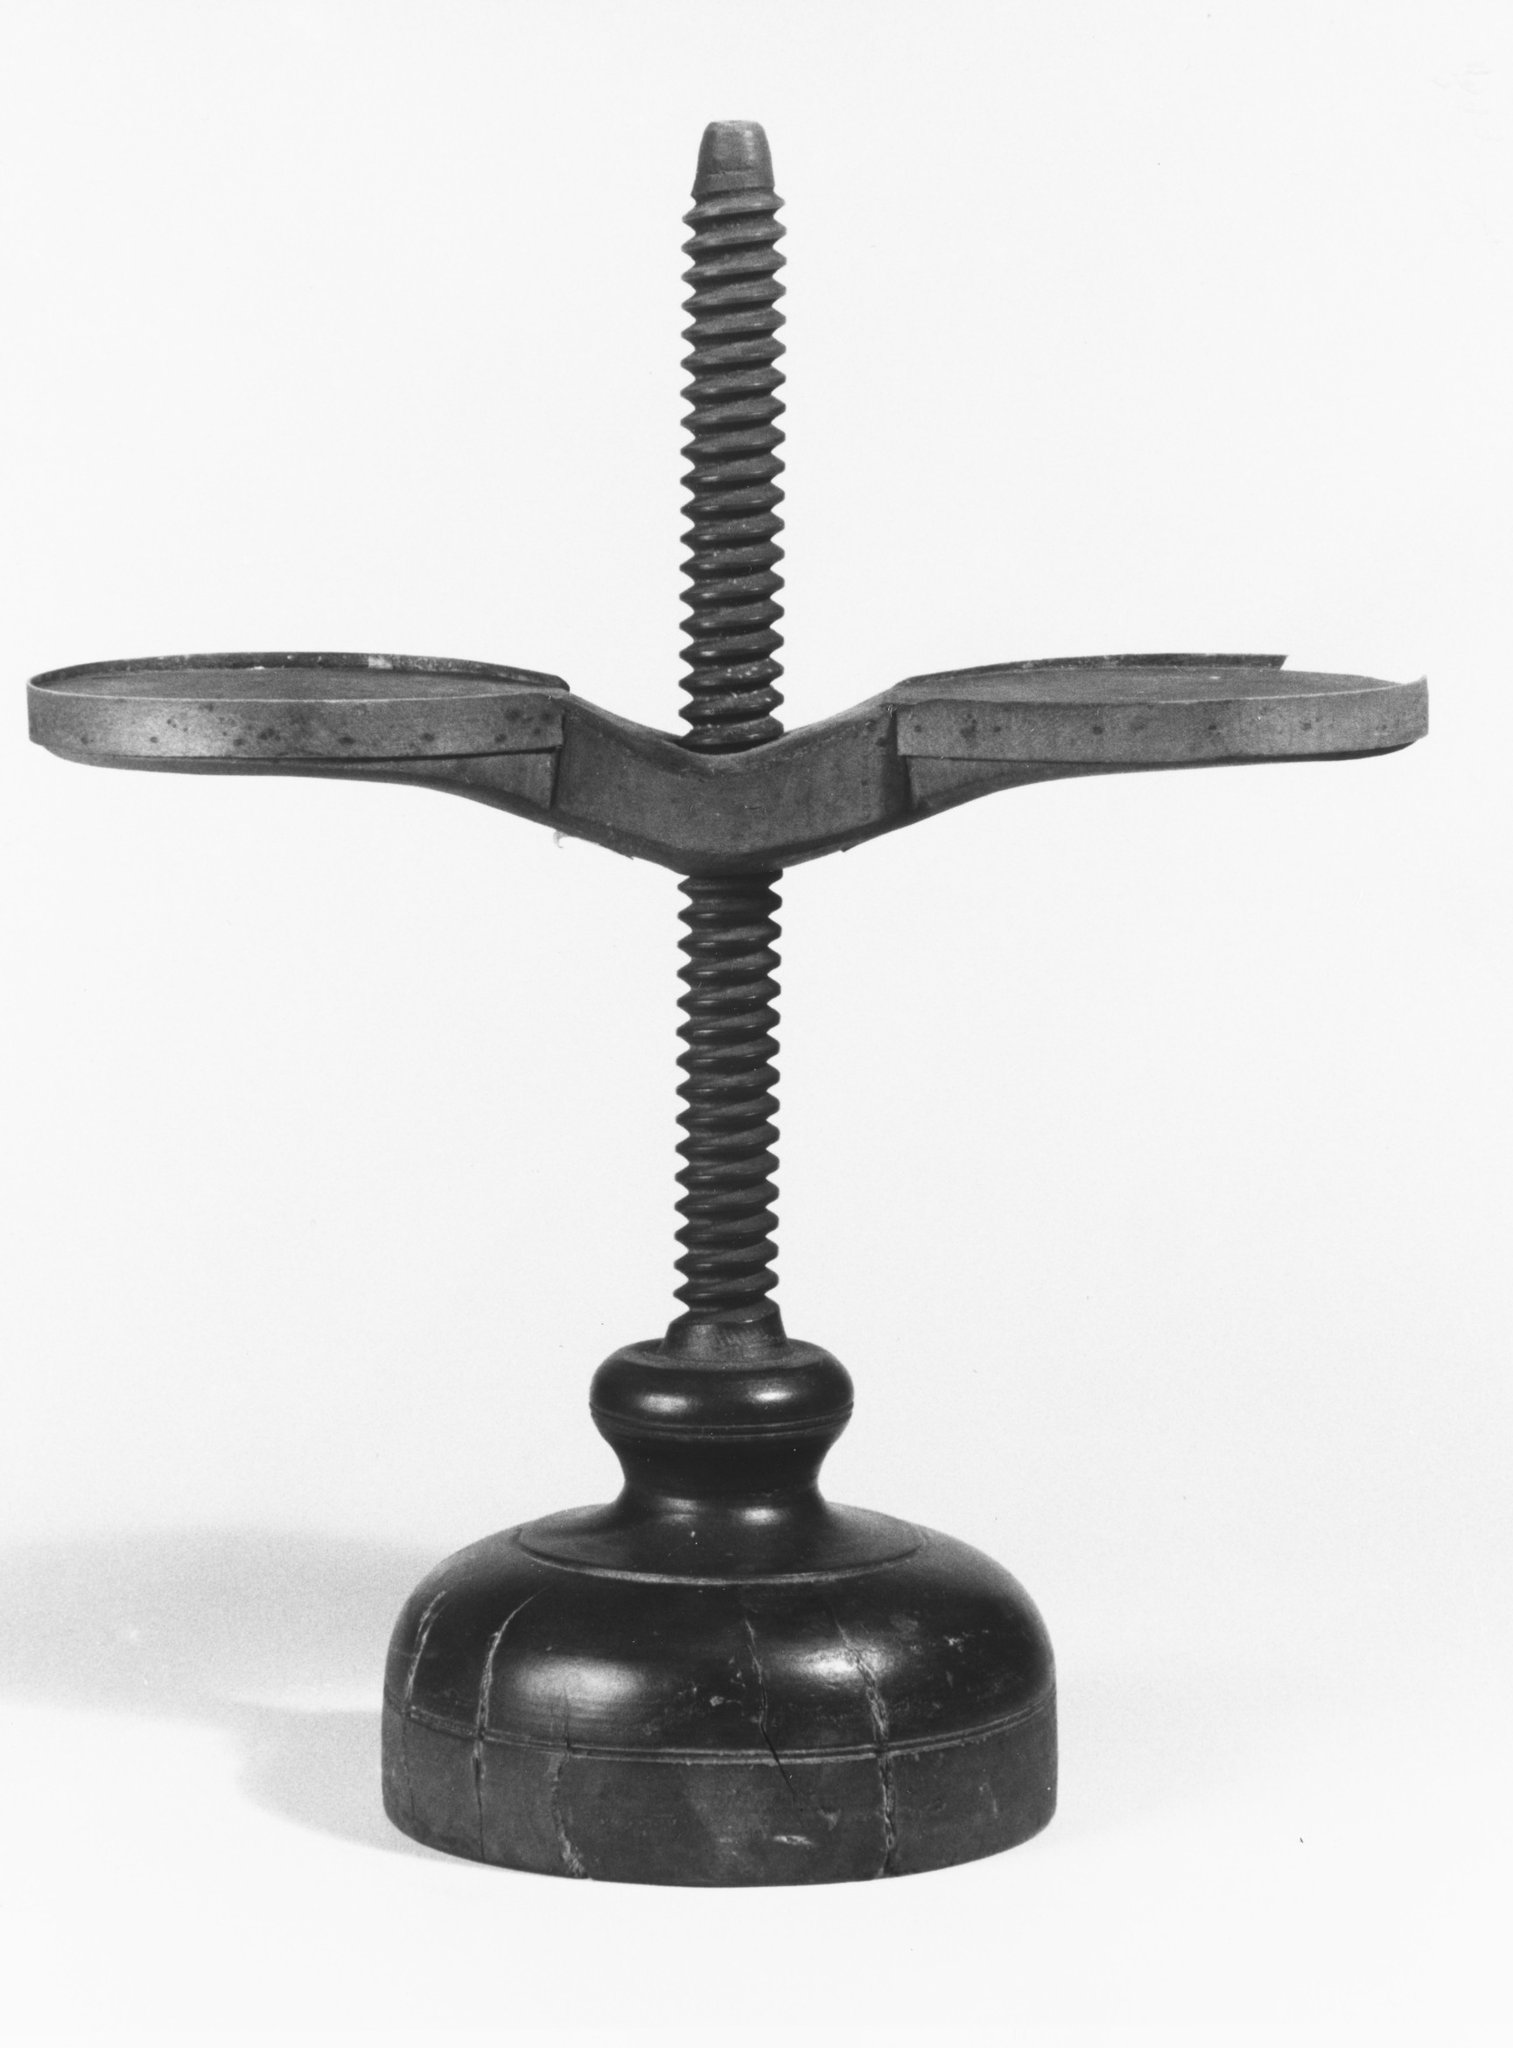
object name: candle stand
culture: american, shaker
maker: united society of believers in christ’s second appearing (“shakers”)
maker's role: maker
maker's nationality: american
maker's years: 1750-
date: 1800-1840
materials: wood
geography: united states